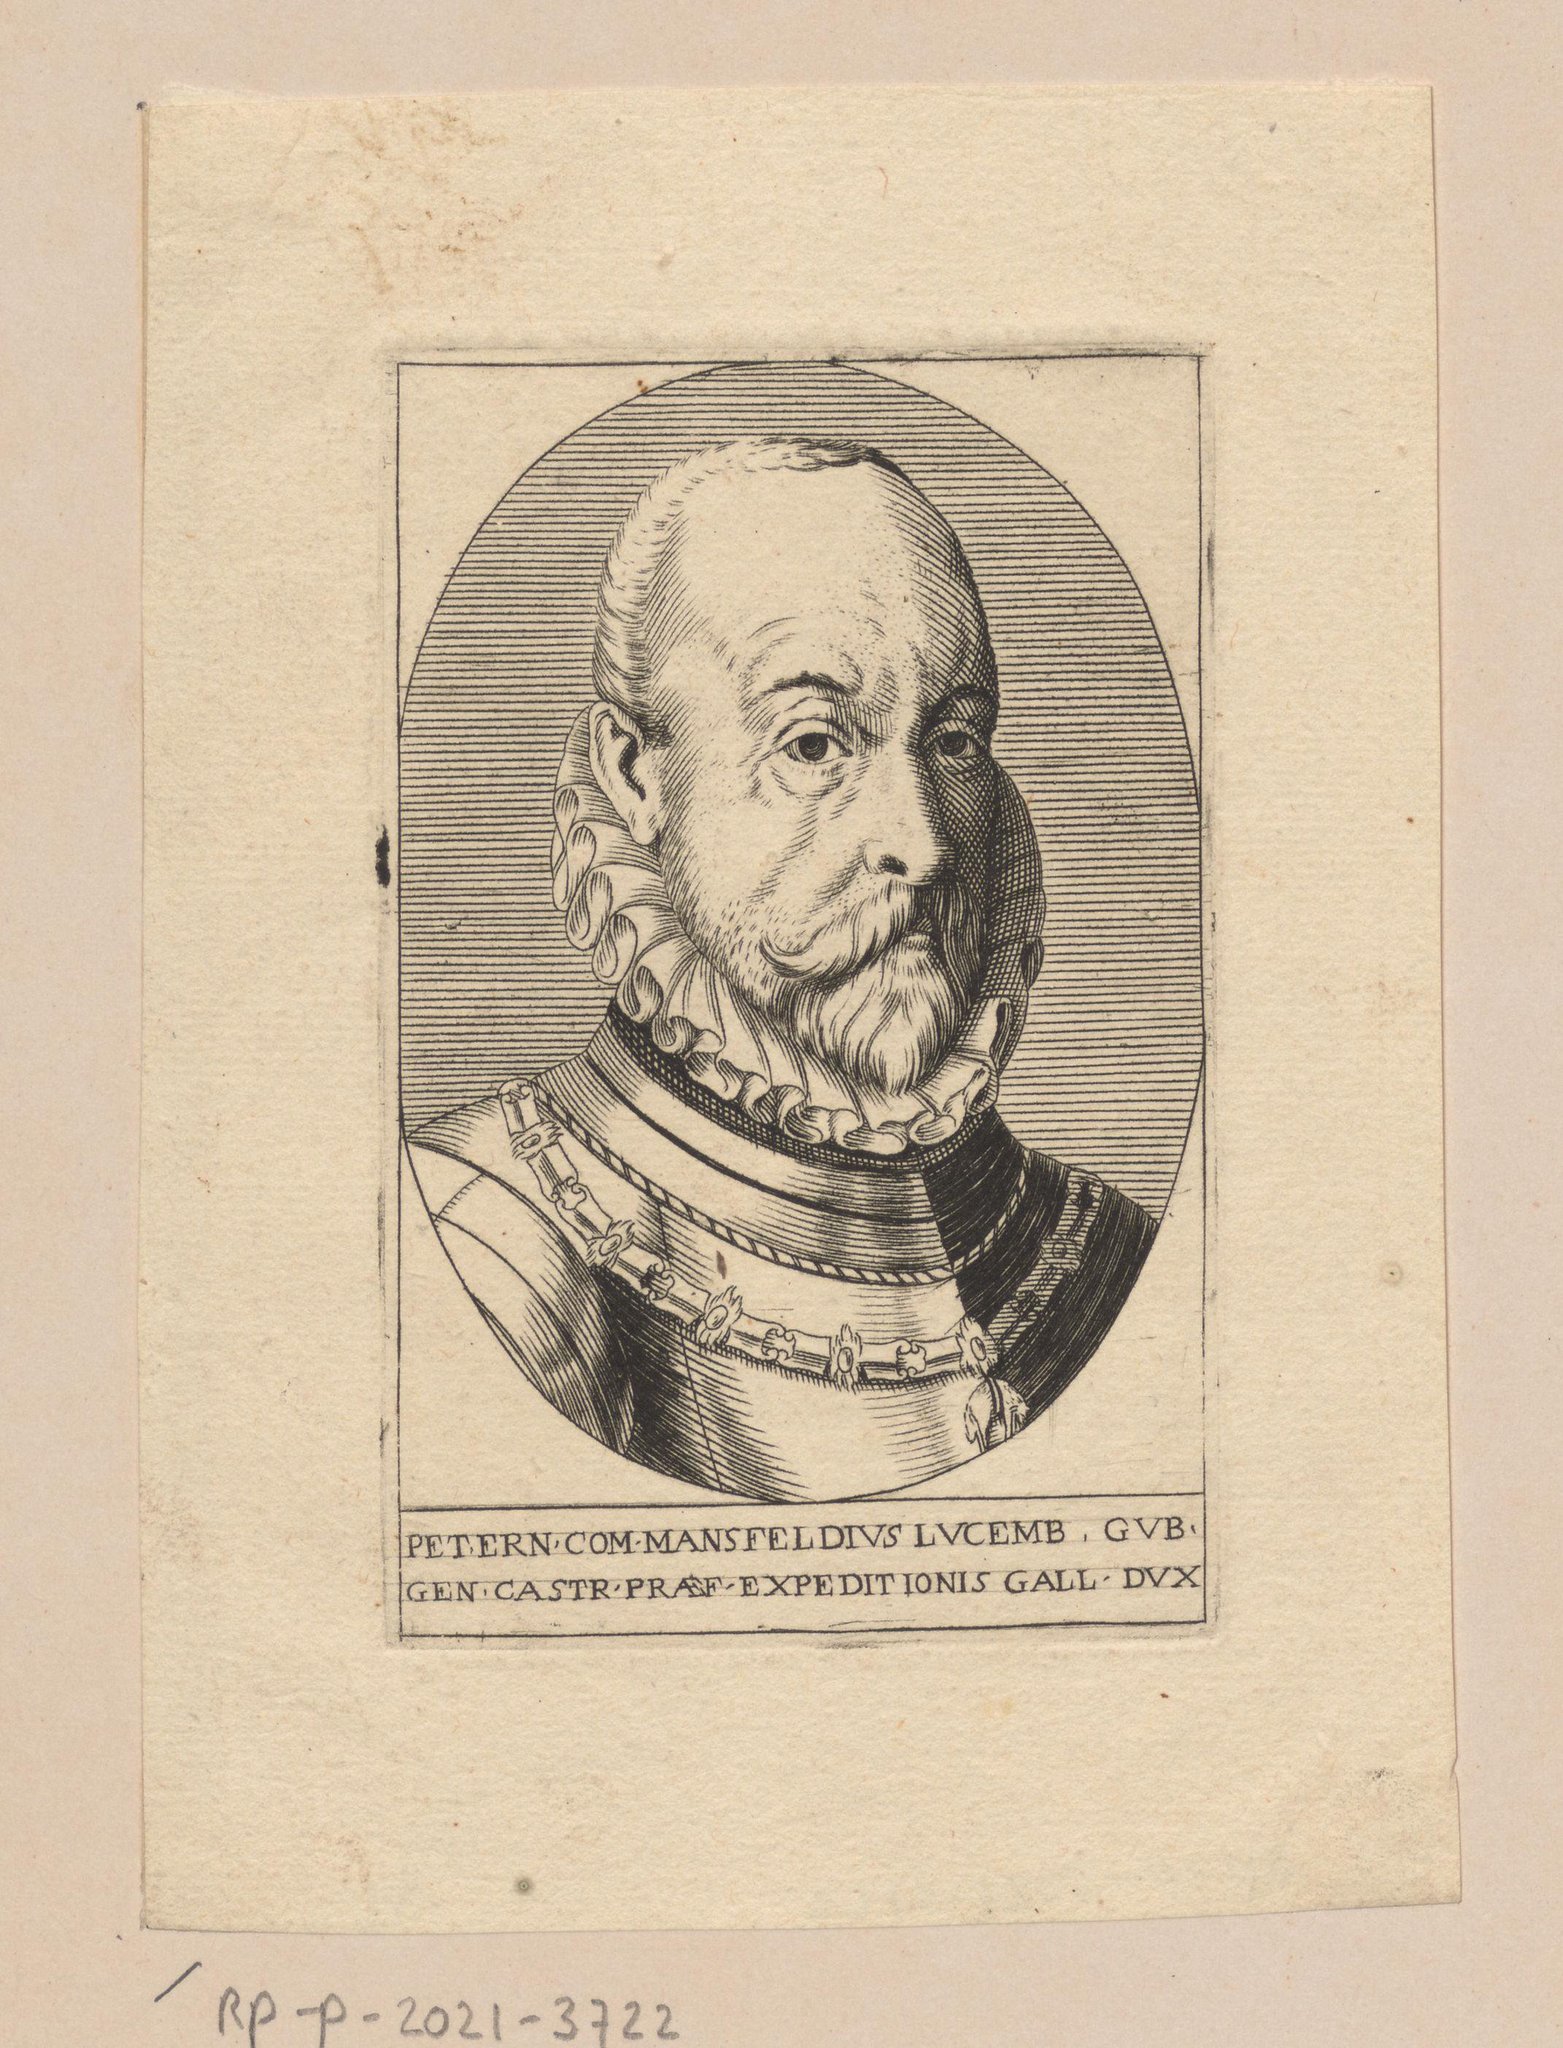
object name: print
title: Portret van Peter Ernst I van Mansfeld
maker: Anonymous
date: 1650-1750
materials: paper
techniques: engraving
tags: armour, historical persons, knighthood order of the golden fleece - insignia of a knighthood order, e.g.: badge, chain (with name of order)